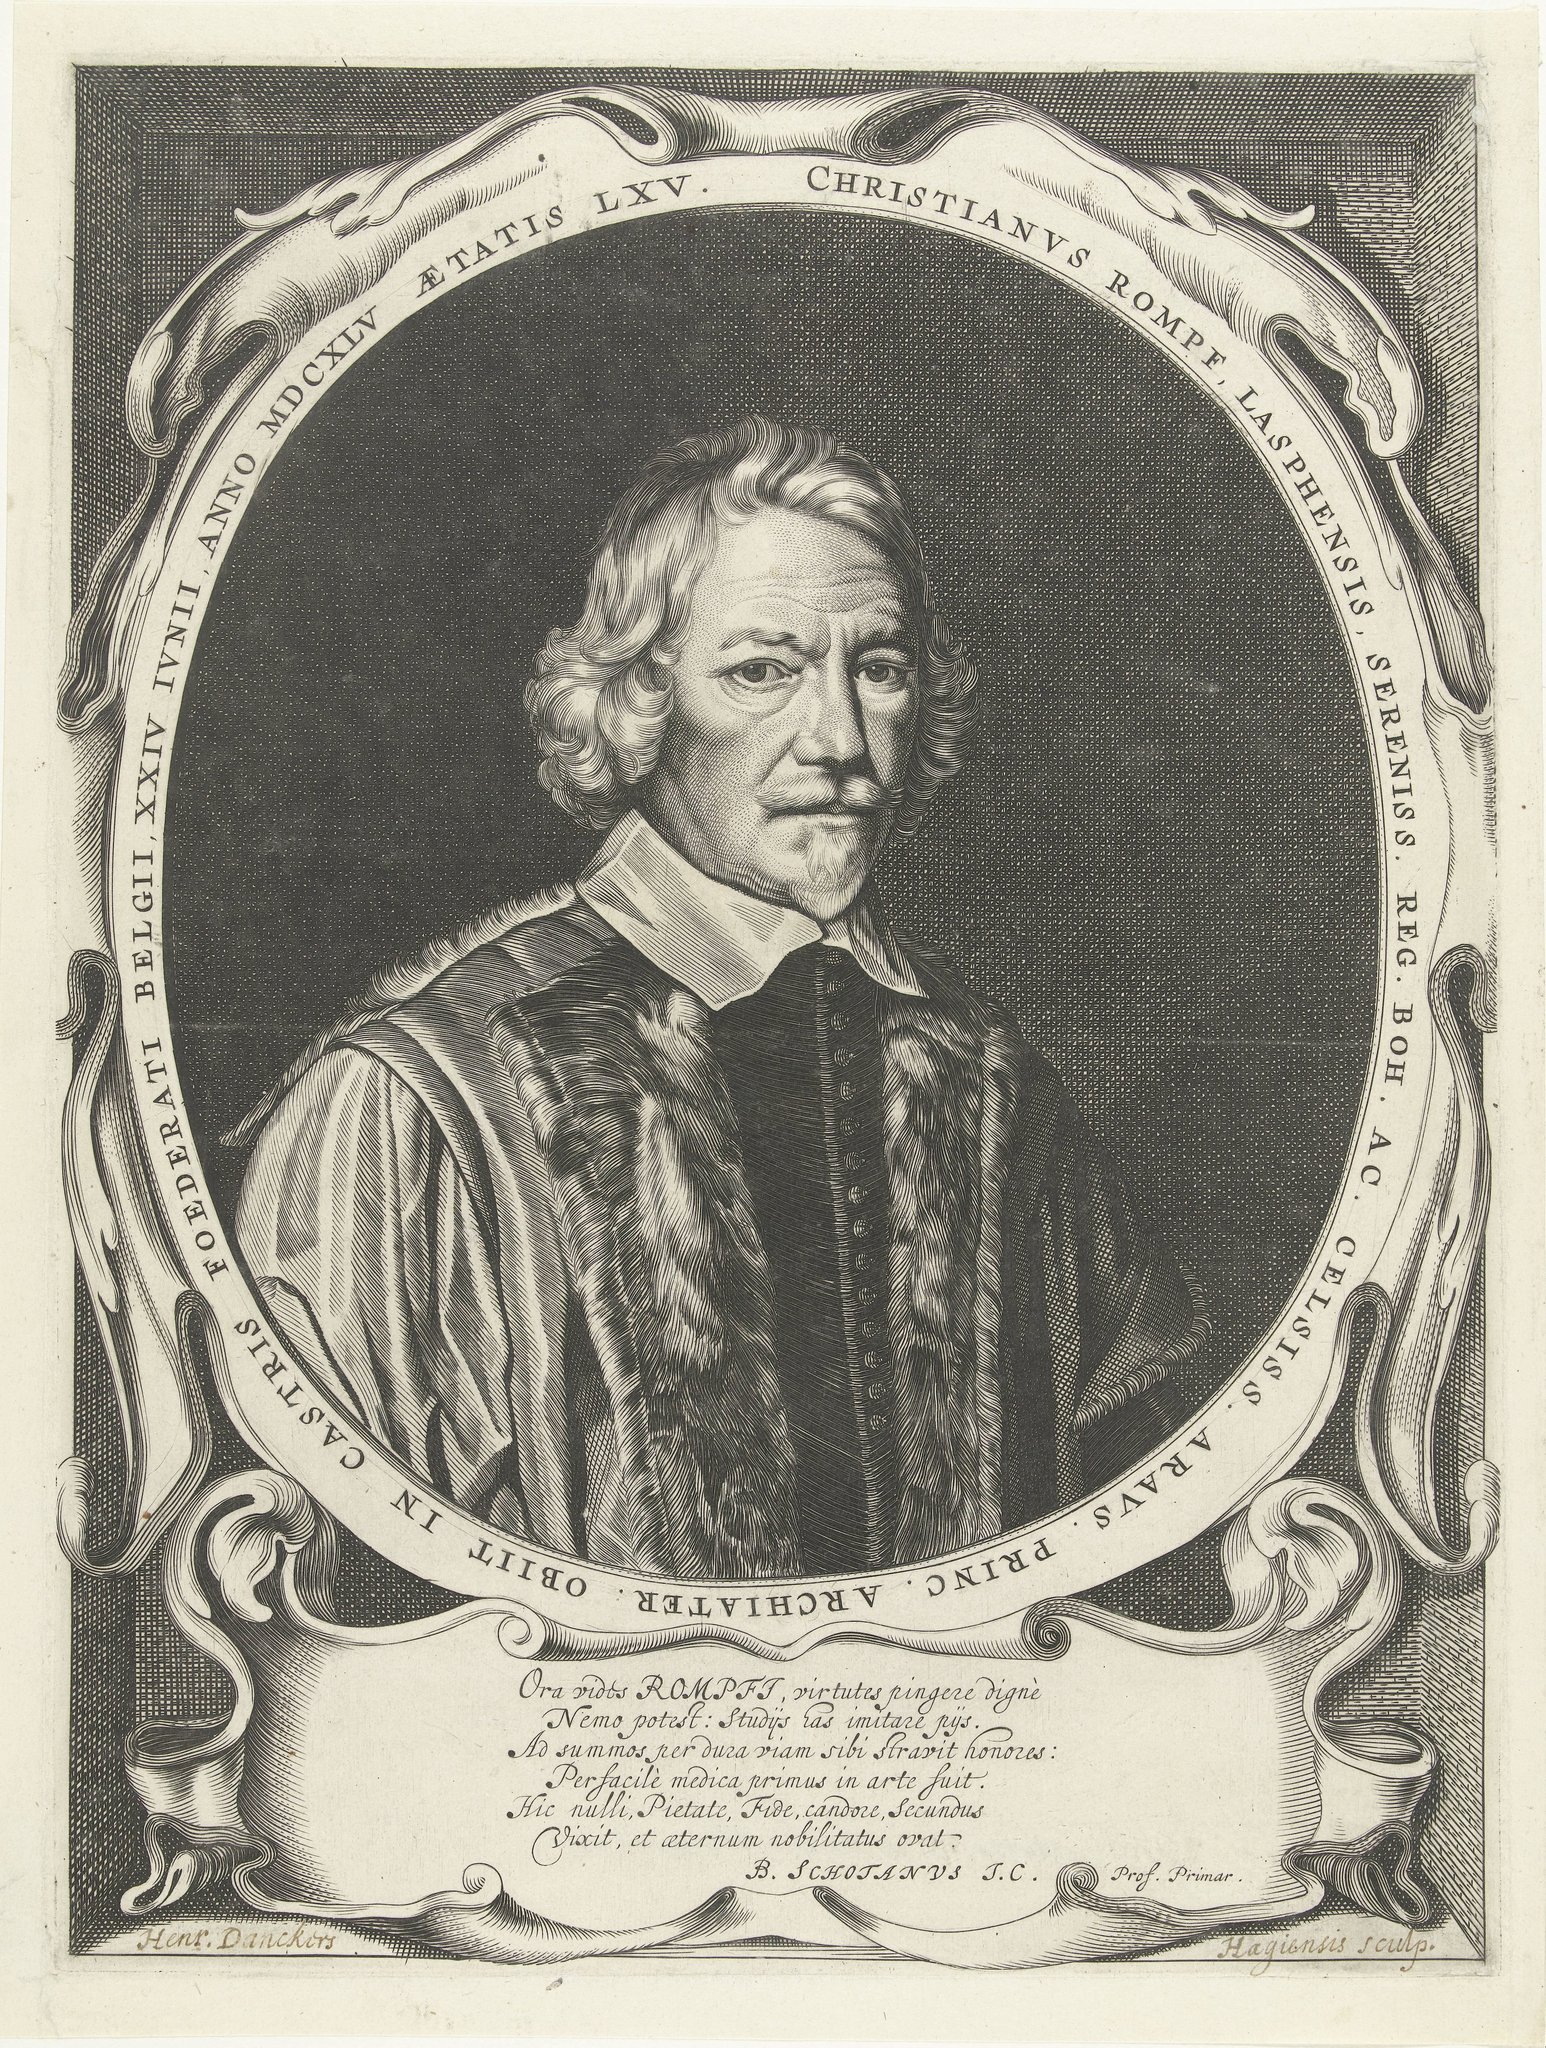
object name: print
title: Christianvs Rompf, Lasphensis, (...) anno MDCXLV aetatis LXV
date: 1645-1657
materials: paper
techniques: engraving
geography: the hague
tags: physician, doctor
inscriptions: collector's mark: Lugt 240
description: Portret van Christiaan Rumpf op 65 jarige leeftijd, buste in ovale omlijsting met rolwerk. Onder portret cartouche met Latijns vers in zes regels door B. Schotanus.